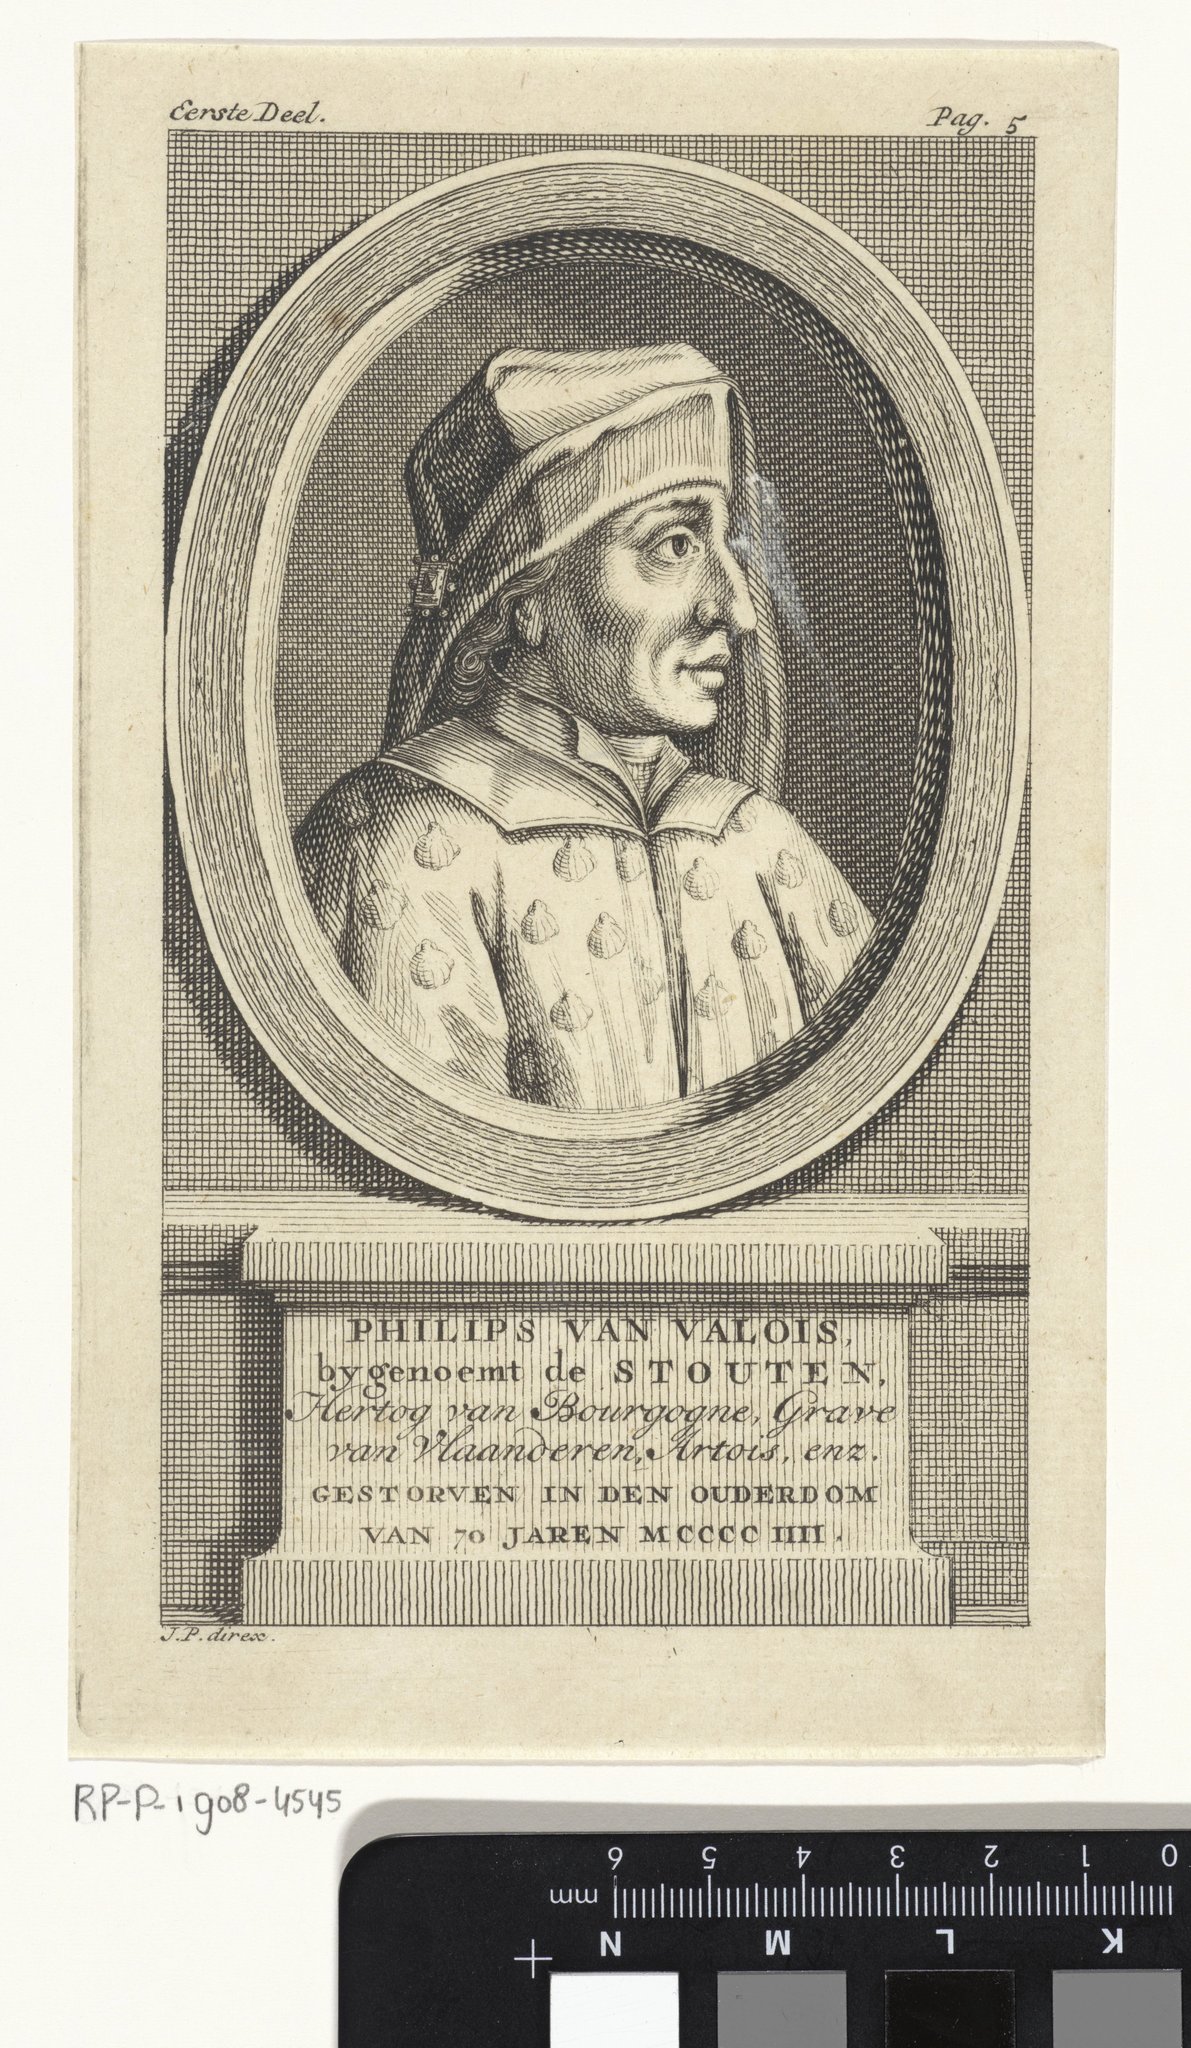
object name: print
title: Portret van Filips II de Stoute, hertog van Bourgondië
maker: jan punt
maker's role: draughtsman, print maker, publisher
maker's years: 1711-1779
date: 1748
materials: paper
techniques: engraving, etching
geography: northern netherlands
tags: halle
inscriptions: collector's mark: Lugt 2228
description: Illustratie uit: Meteren, Emanuel van. Historie van de oorlogen en geschiedenissen der Nederlanderen, en der zelver naburen: beginnende met den jare 1315, en eindigende met den jare 1611, deel I, p. 5. Gorinchem/Breda: Nicolaas Goetzee, Pieter Goetzee/Willem Goetzee, 1748.